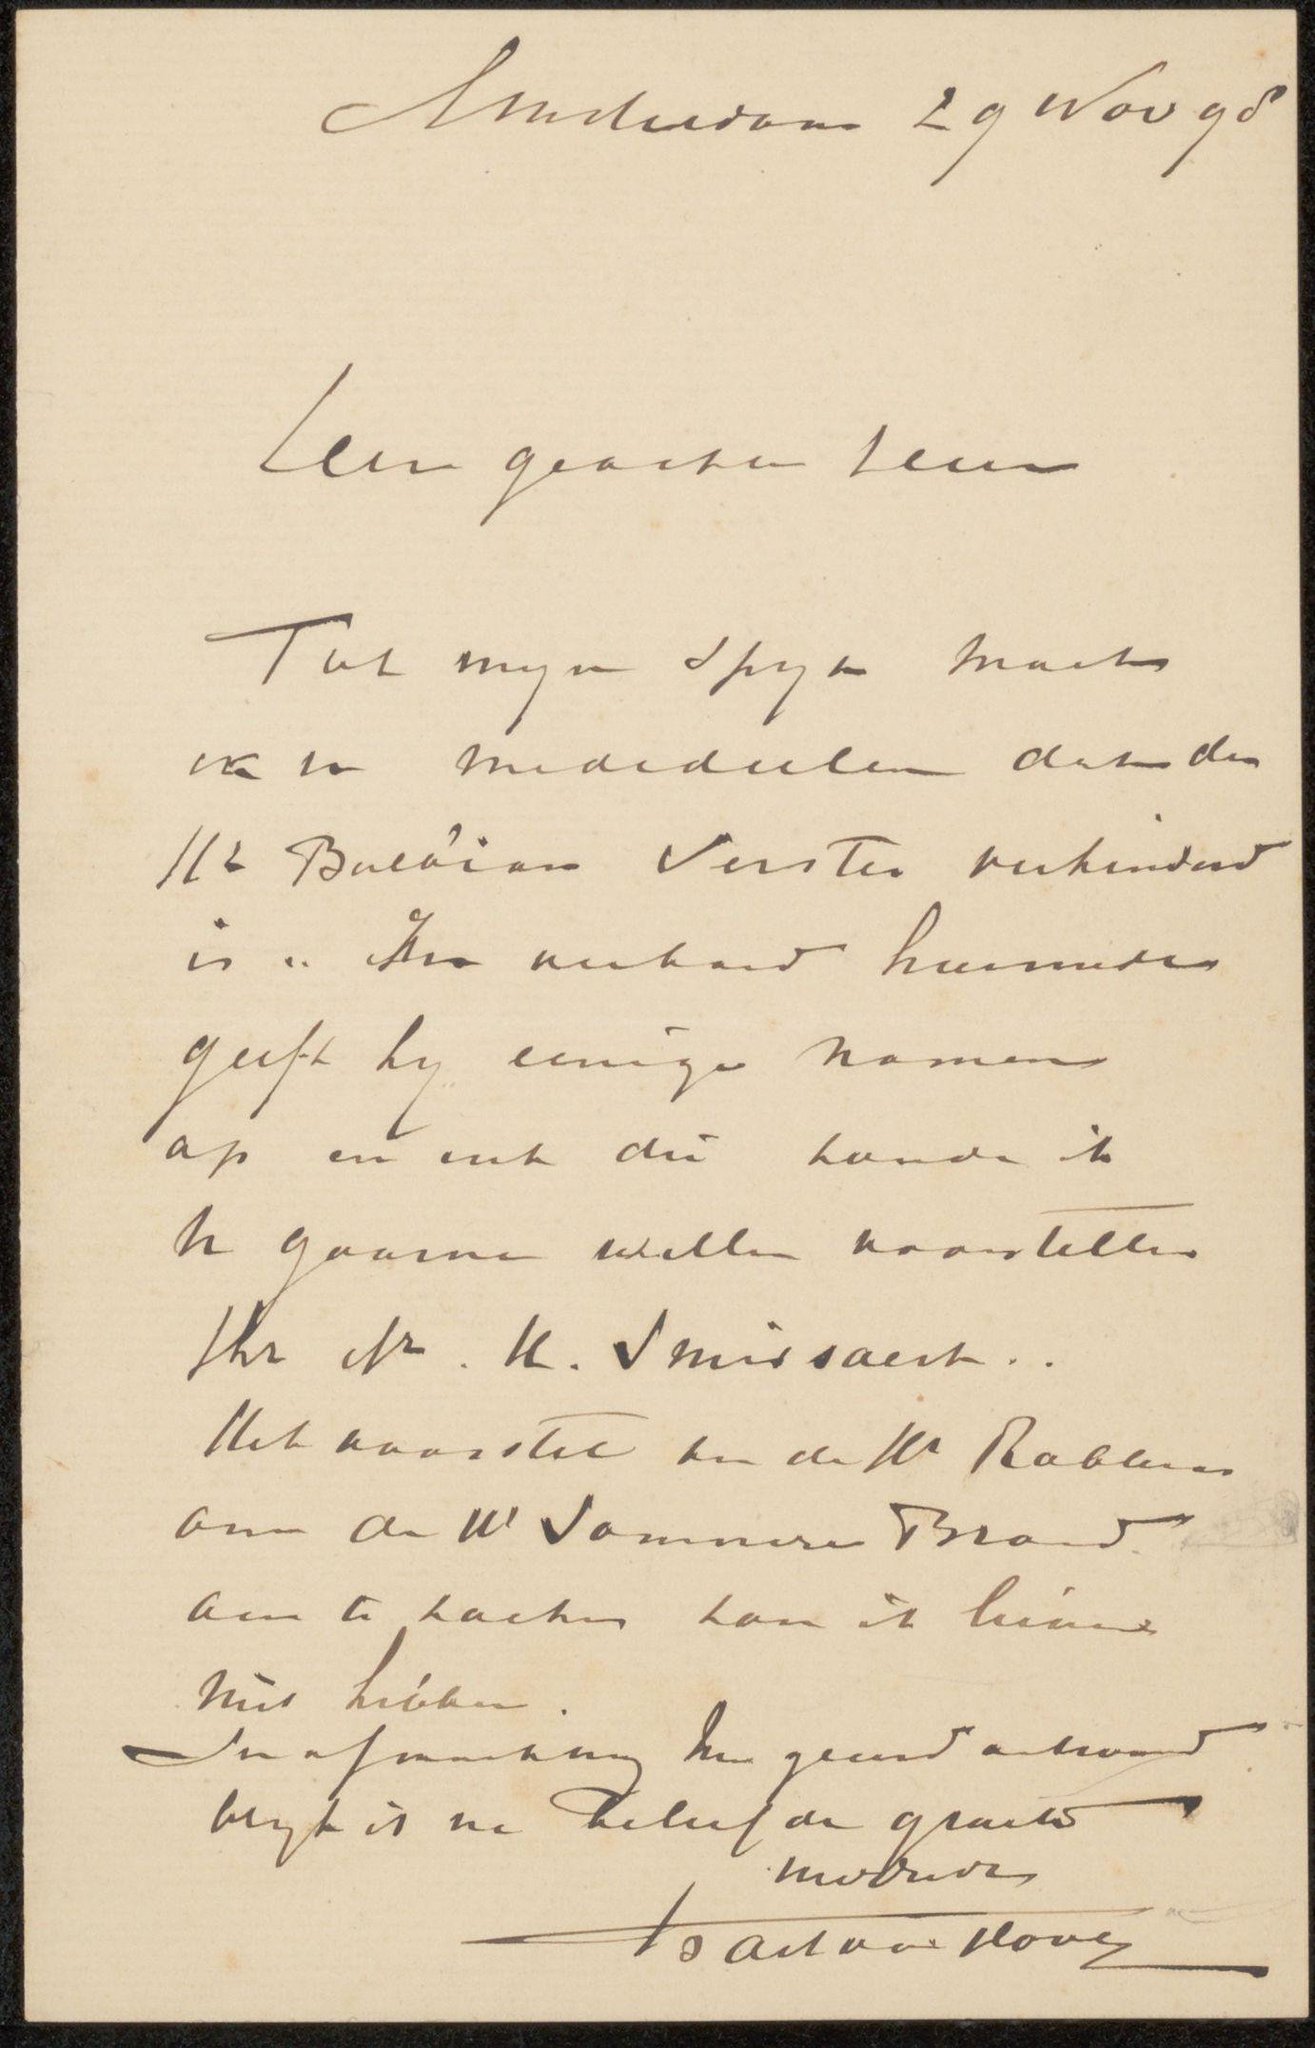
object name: letter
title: Brief aan Philip Zilcken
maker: bart van hove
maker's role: sculptor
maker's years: 1850-1914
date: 1898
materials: ink, paper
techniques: pen, writing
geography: amsterdam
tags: the hague, print maker, draughtsman, frans smissaert, amsterdam, abraham henricus de balbian verster, painter, philip zilcken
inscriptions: collector's mark: ‘RPK’